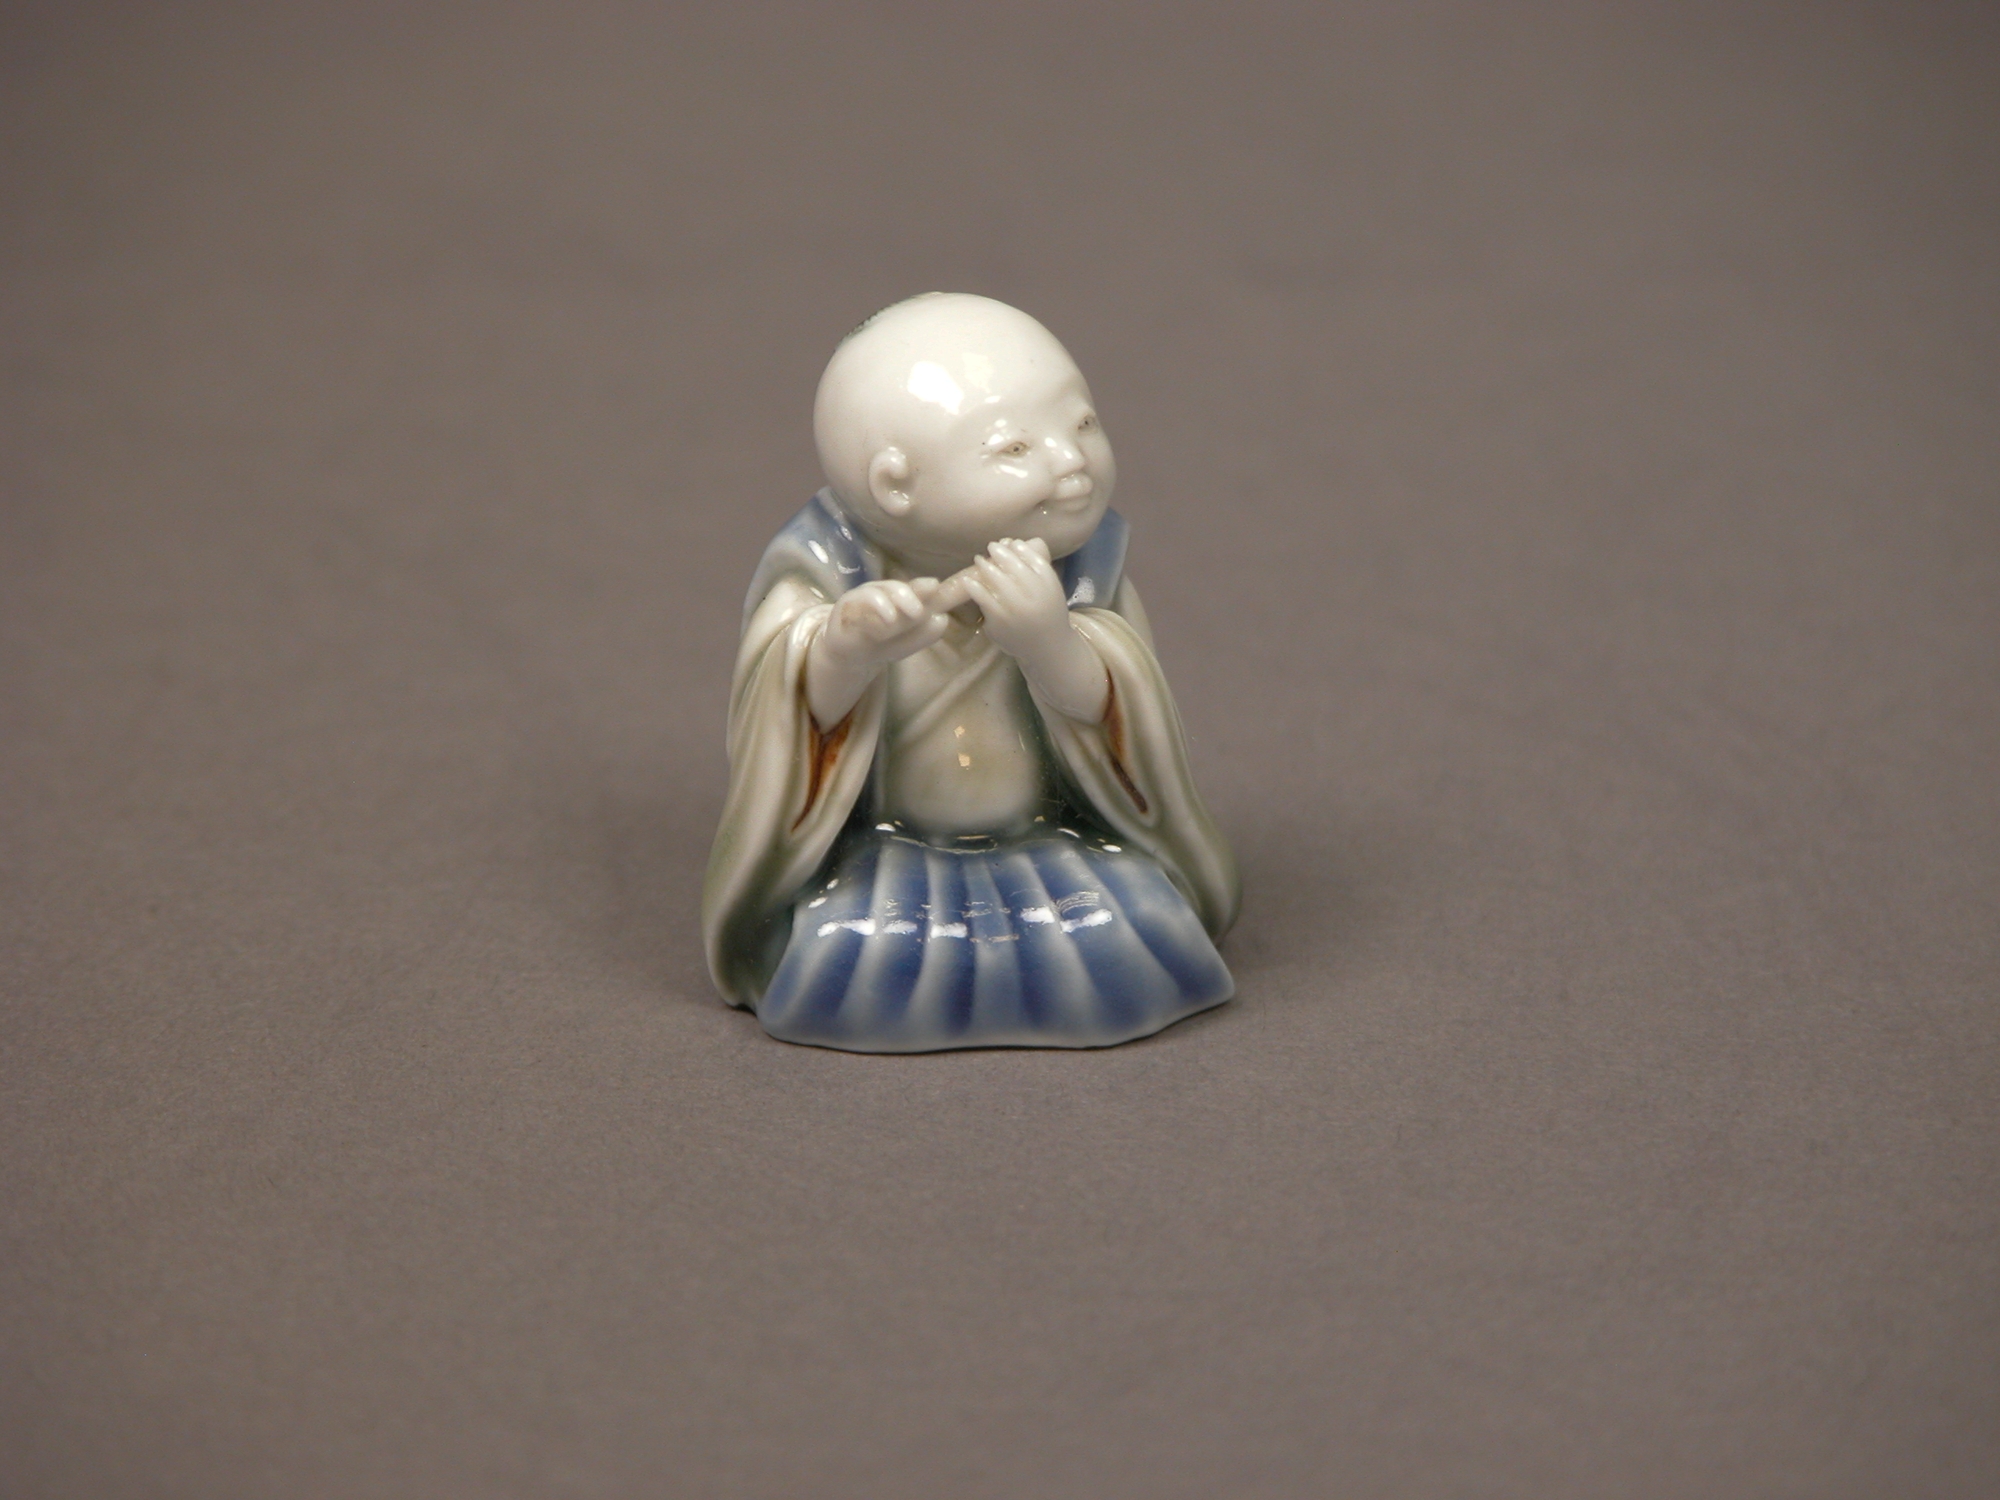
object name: figure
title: Chinese child with musical instrument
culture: japanese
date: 1767-1800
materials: iron, porcelain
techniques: underglaze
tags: musical instruments,boys